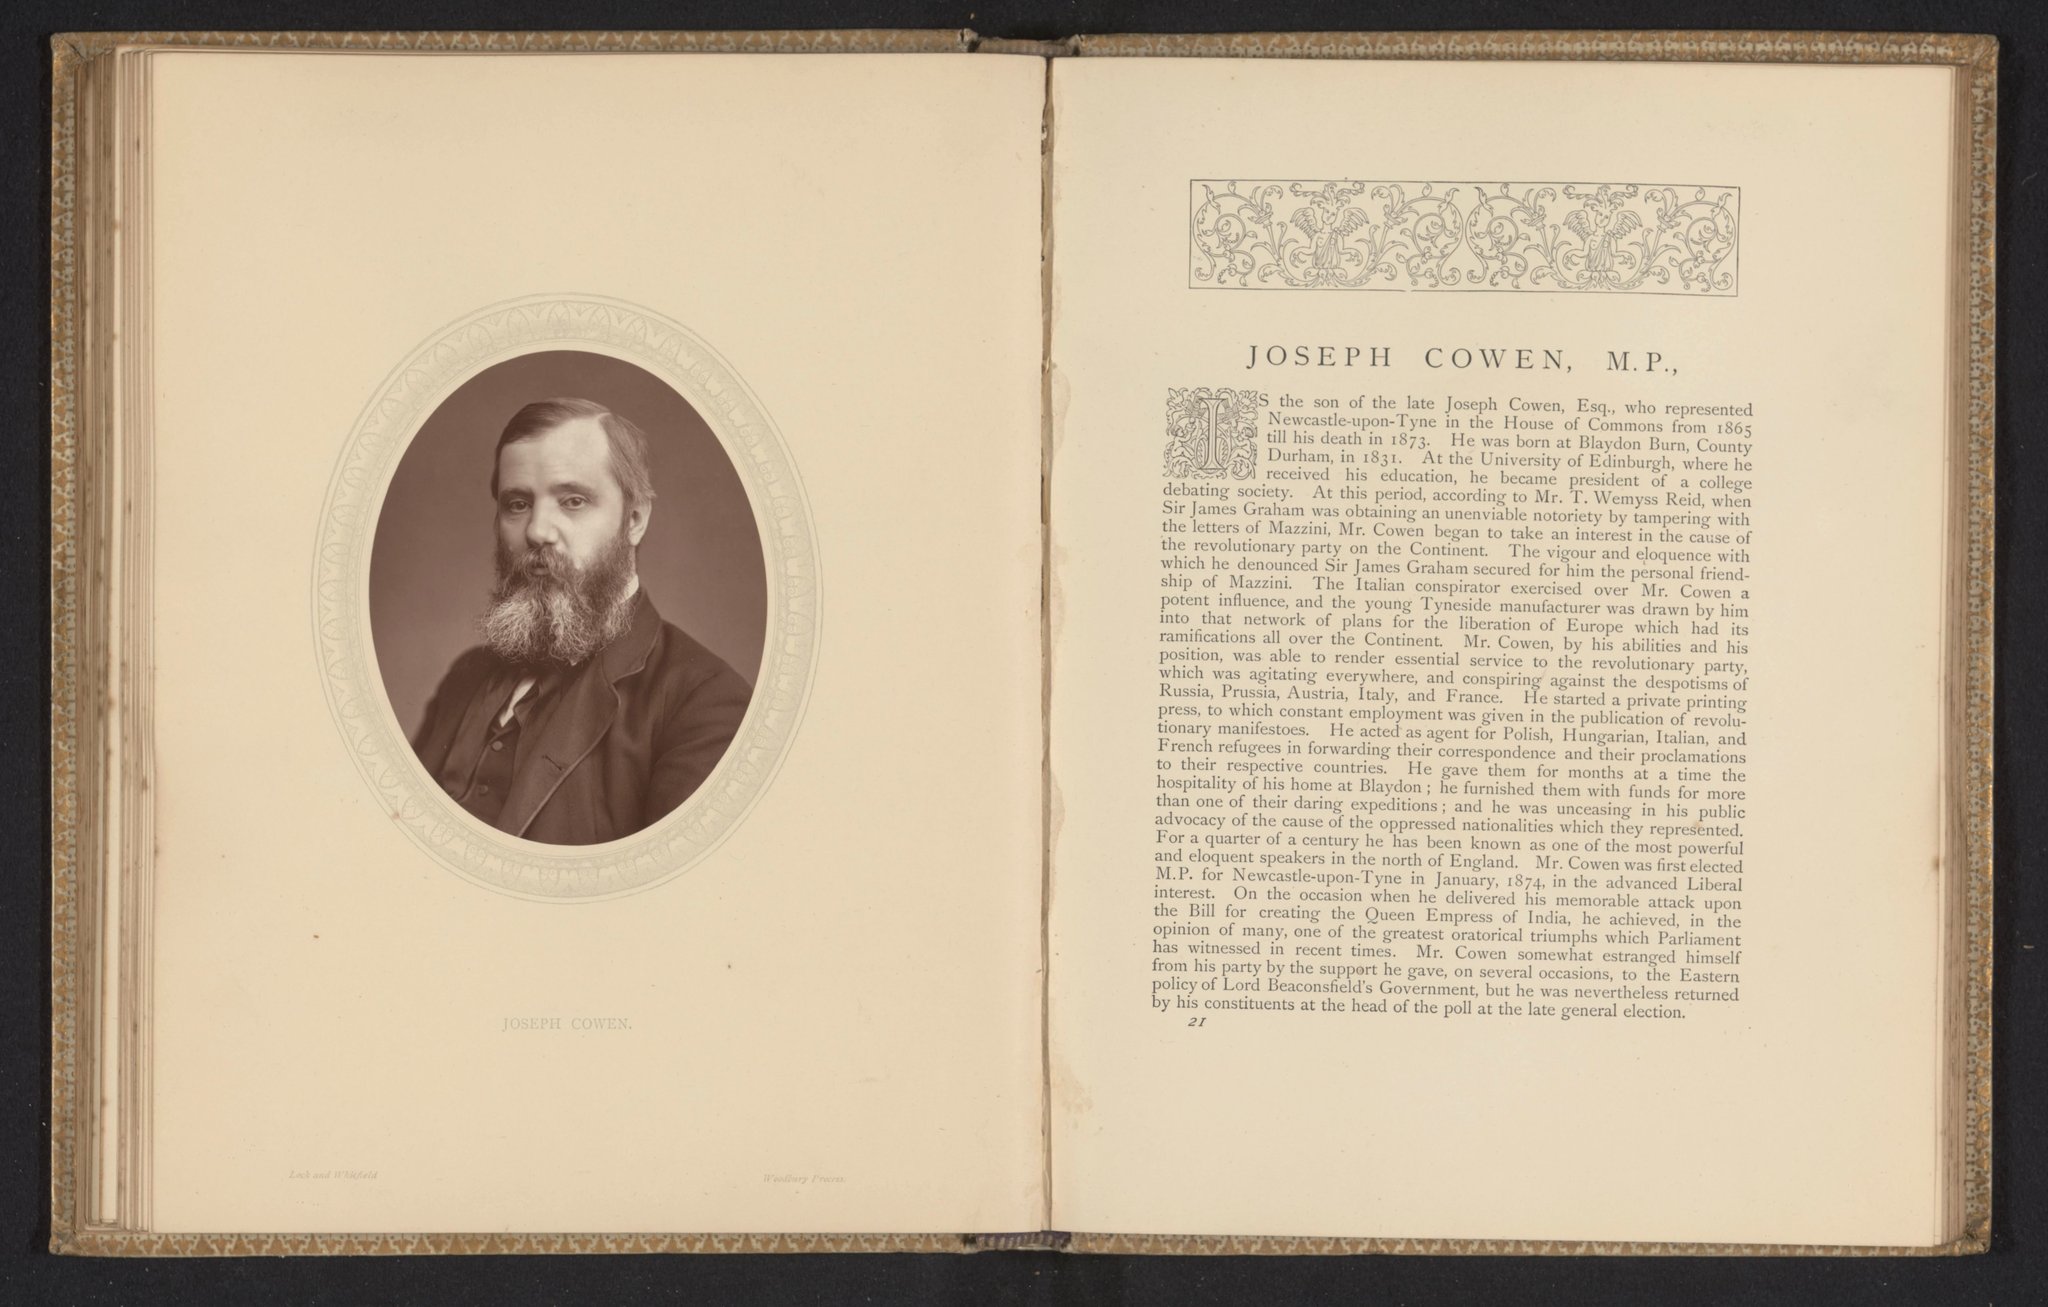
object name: photomechanical print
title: Joseph Cowen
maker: Anonymous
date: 1876-1881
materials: paper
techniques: woodburytype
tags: journalist, reporter, historical persons (portraits and scenes from the life) (+ (full) bust portrait)